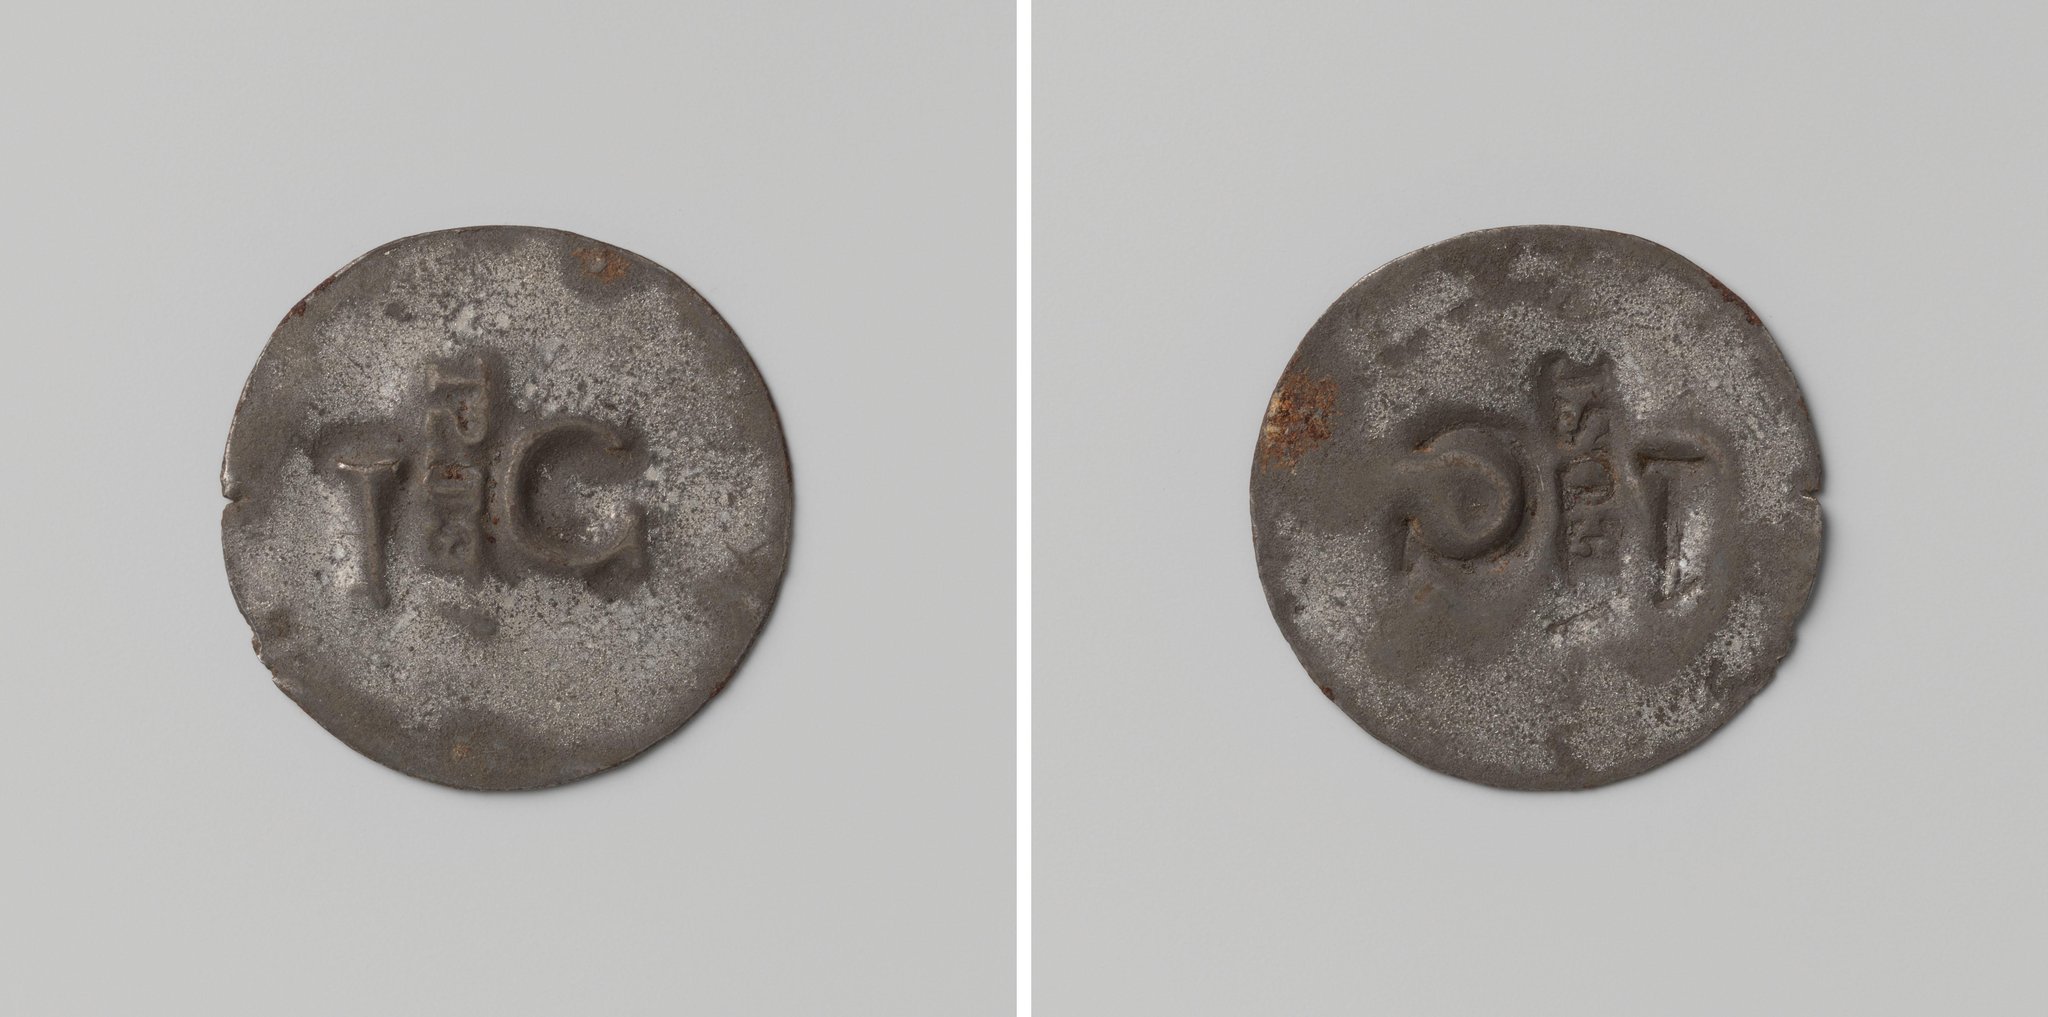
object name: cent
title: Strafkolonie Ommerschans(?), huismunt ter waarde van 1 cent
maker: d.a. schretlen junior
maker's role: blikslager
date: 1827-1830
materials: silver, metal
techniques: silvering, striking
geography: leiden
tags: elst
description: eenzijdige betaalpenning. Voorzijde: waardeaanduiding; tussen cijfer 1 en letter C: klop met opschrift 'ELST'. Keerzijde: blanco